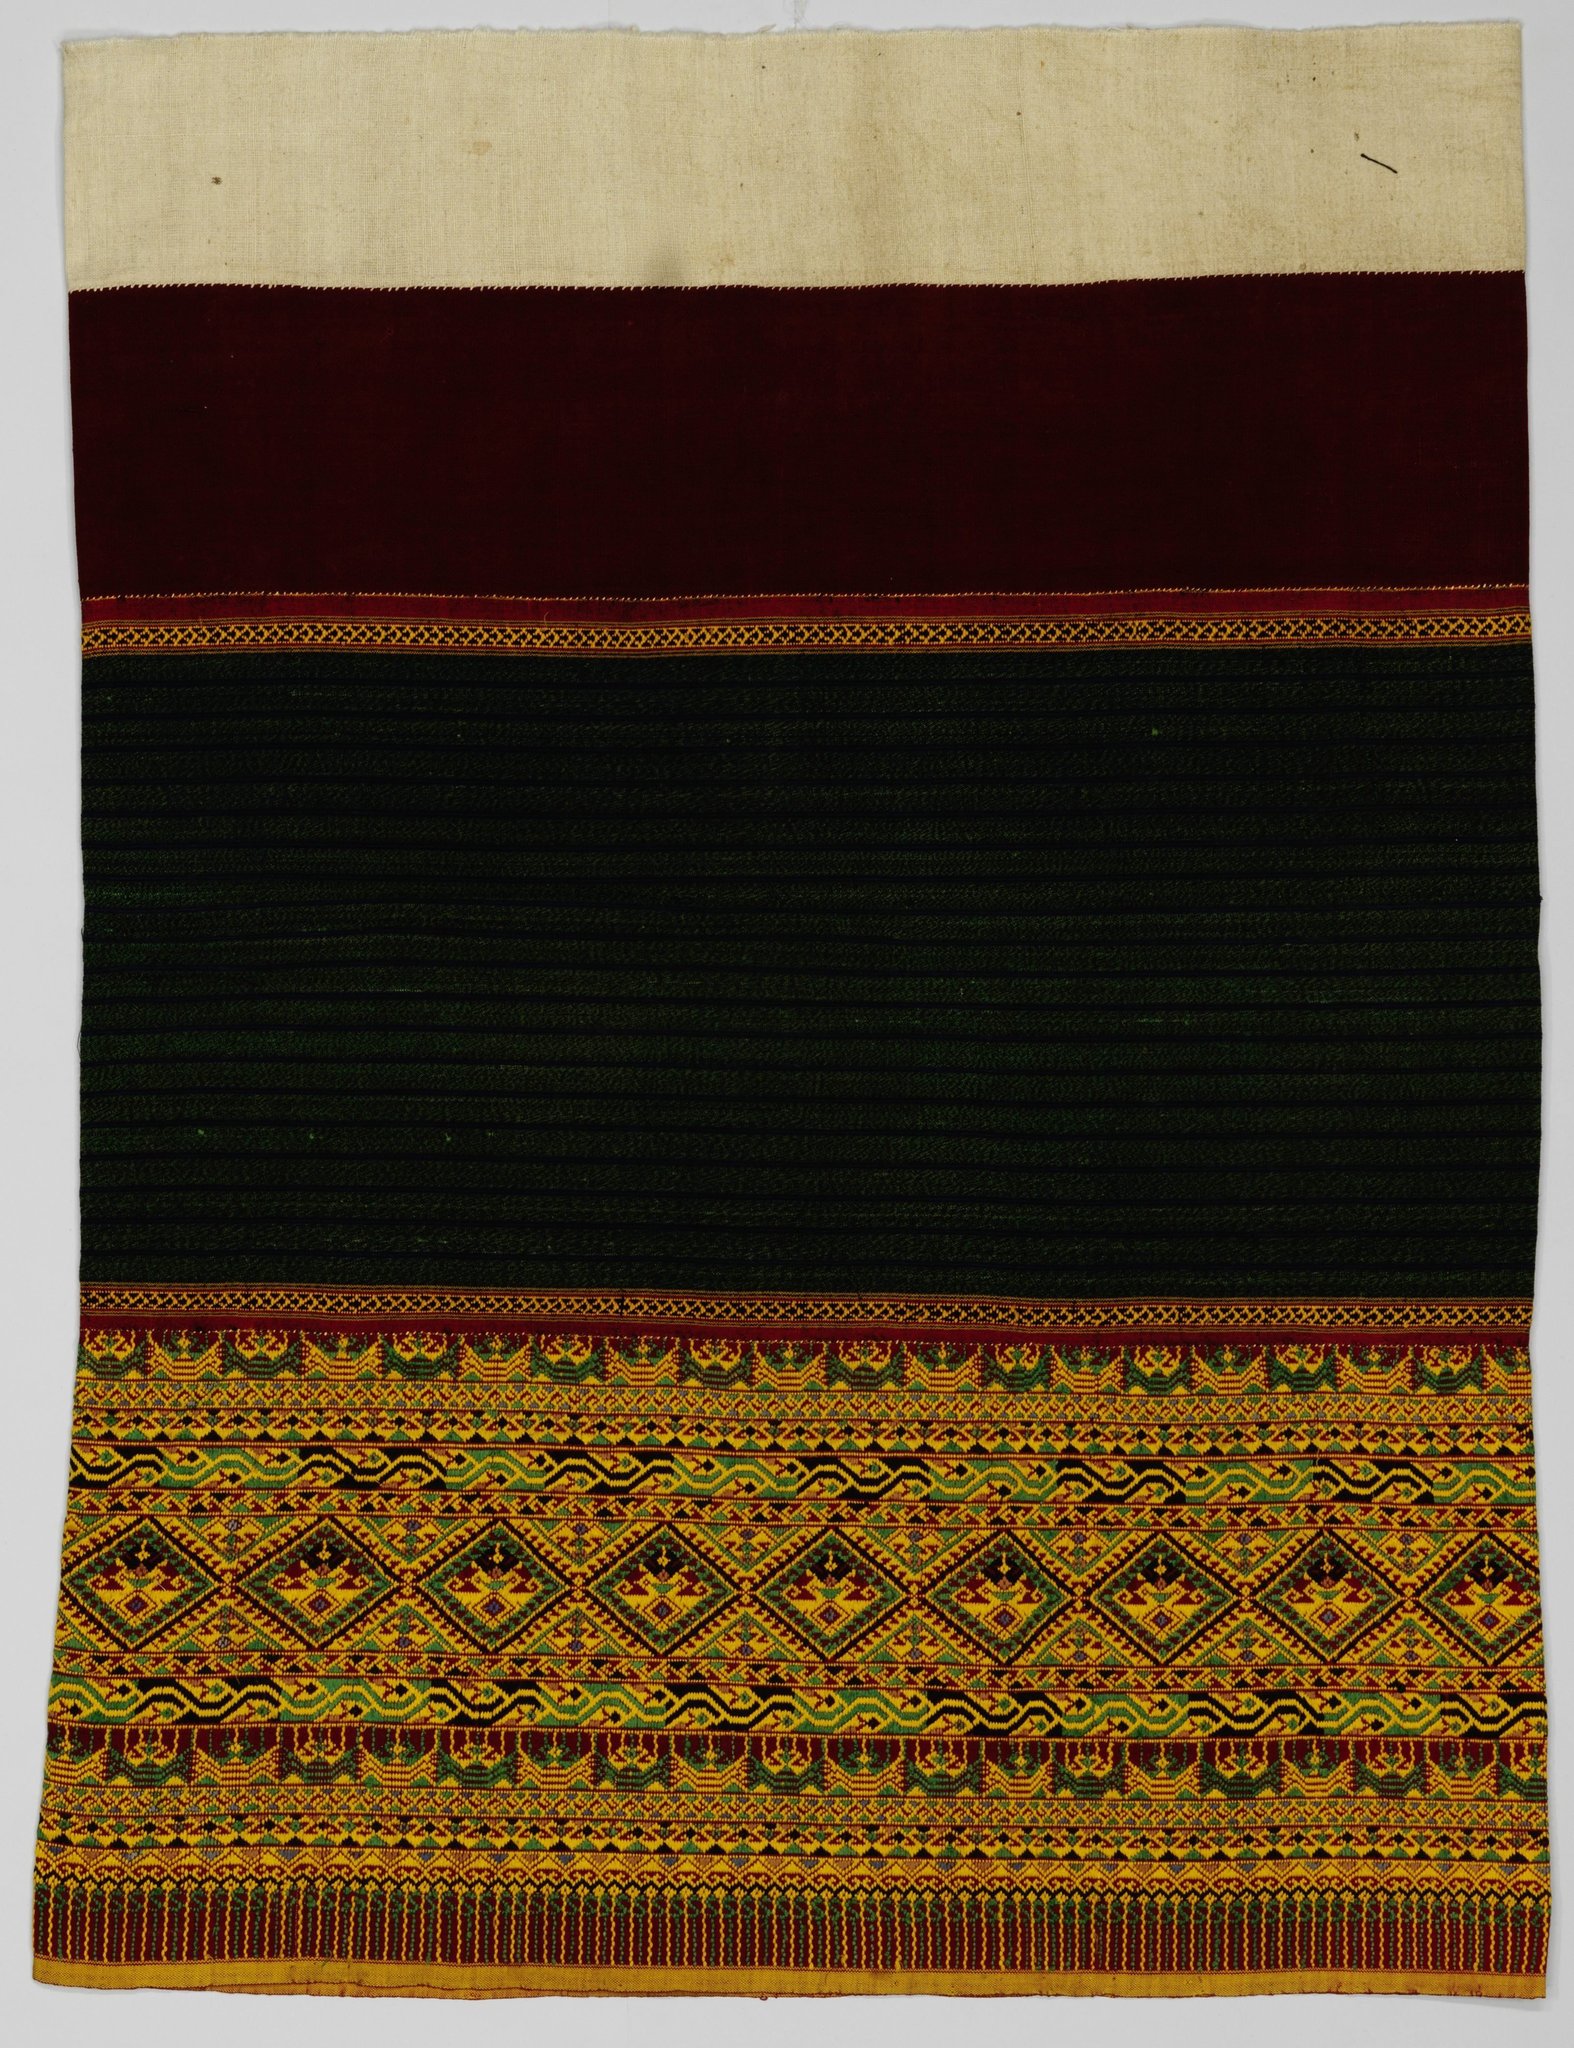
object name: cloth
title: Doek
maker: Anonymous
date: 1900-1949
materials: cotton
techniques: weave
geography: thailand